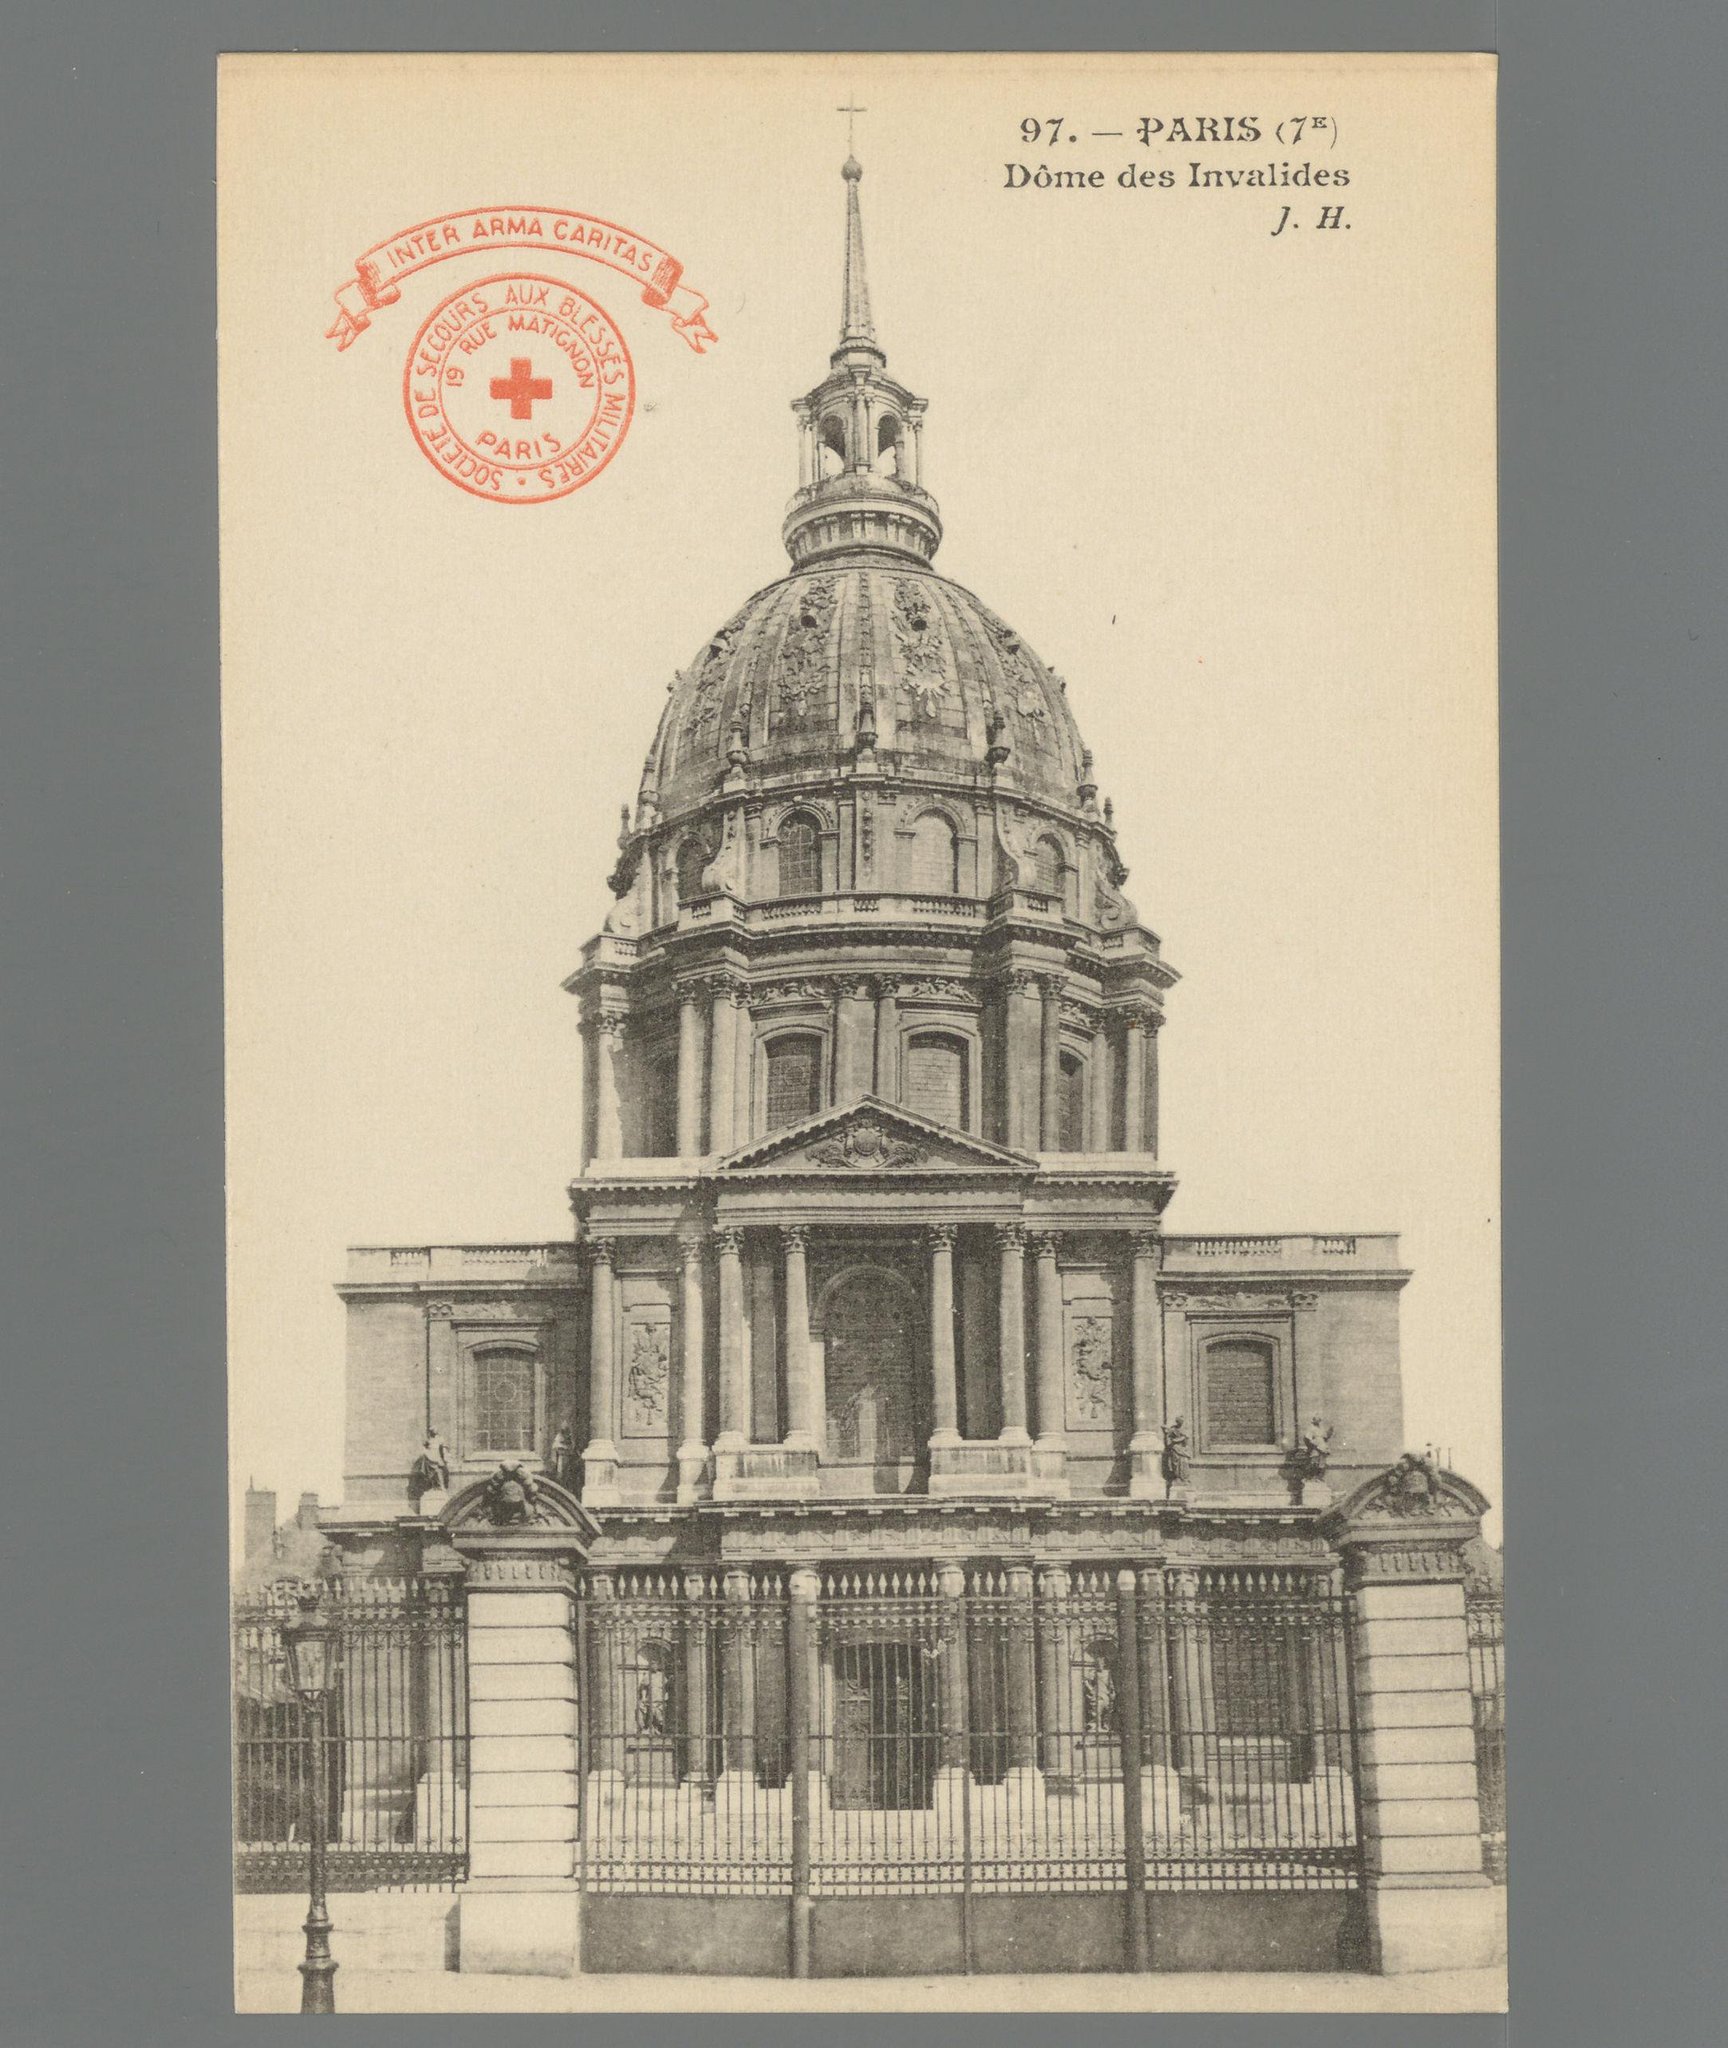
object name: ansichtkaart, prentbriefkaart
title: Paris (7e). Dôme des Invalides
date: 1903-1920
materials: cardboard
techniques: photograph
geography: paris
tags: exterior ~ representation of a building, dome ~ architecture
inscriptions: stamp: ‘Inter Arma Caritas. Société de Secours aux Blessés Militaires. 19 Rue Matignon. Paris’